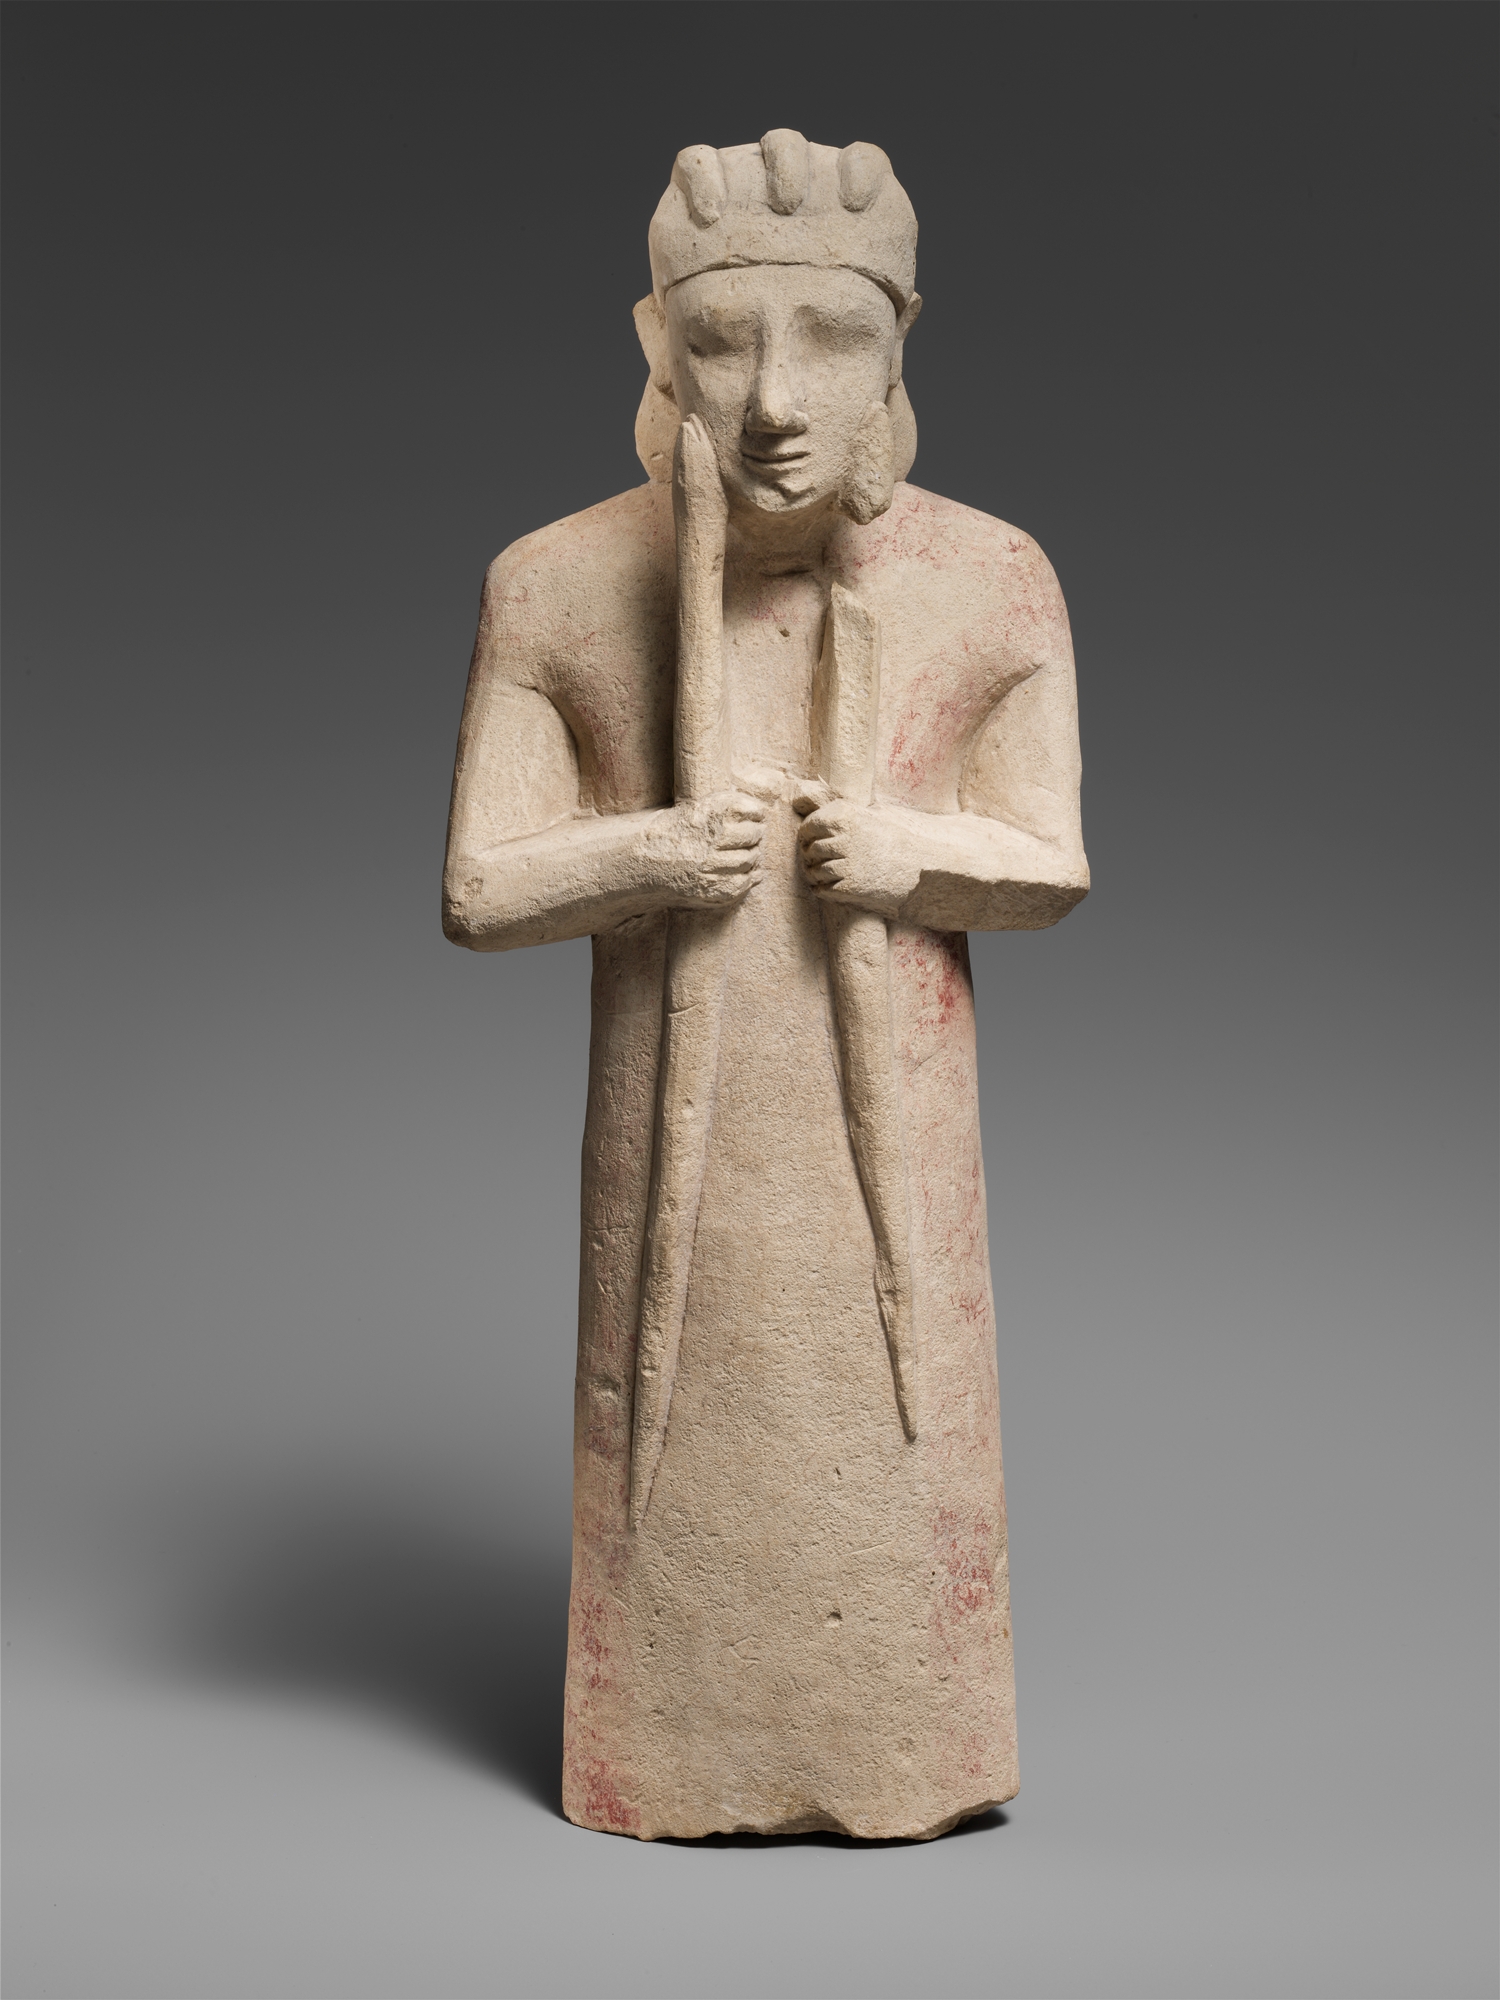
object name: statuette of a snake charmer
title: Limestone snake-charmer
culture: cypriot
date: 600-551 BCE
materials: limestone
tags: men,snakes